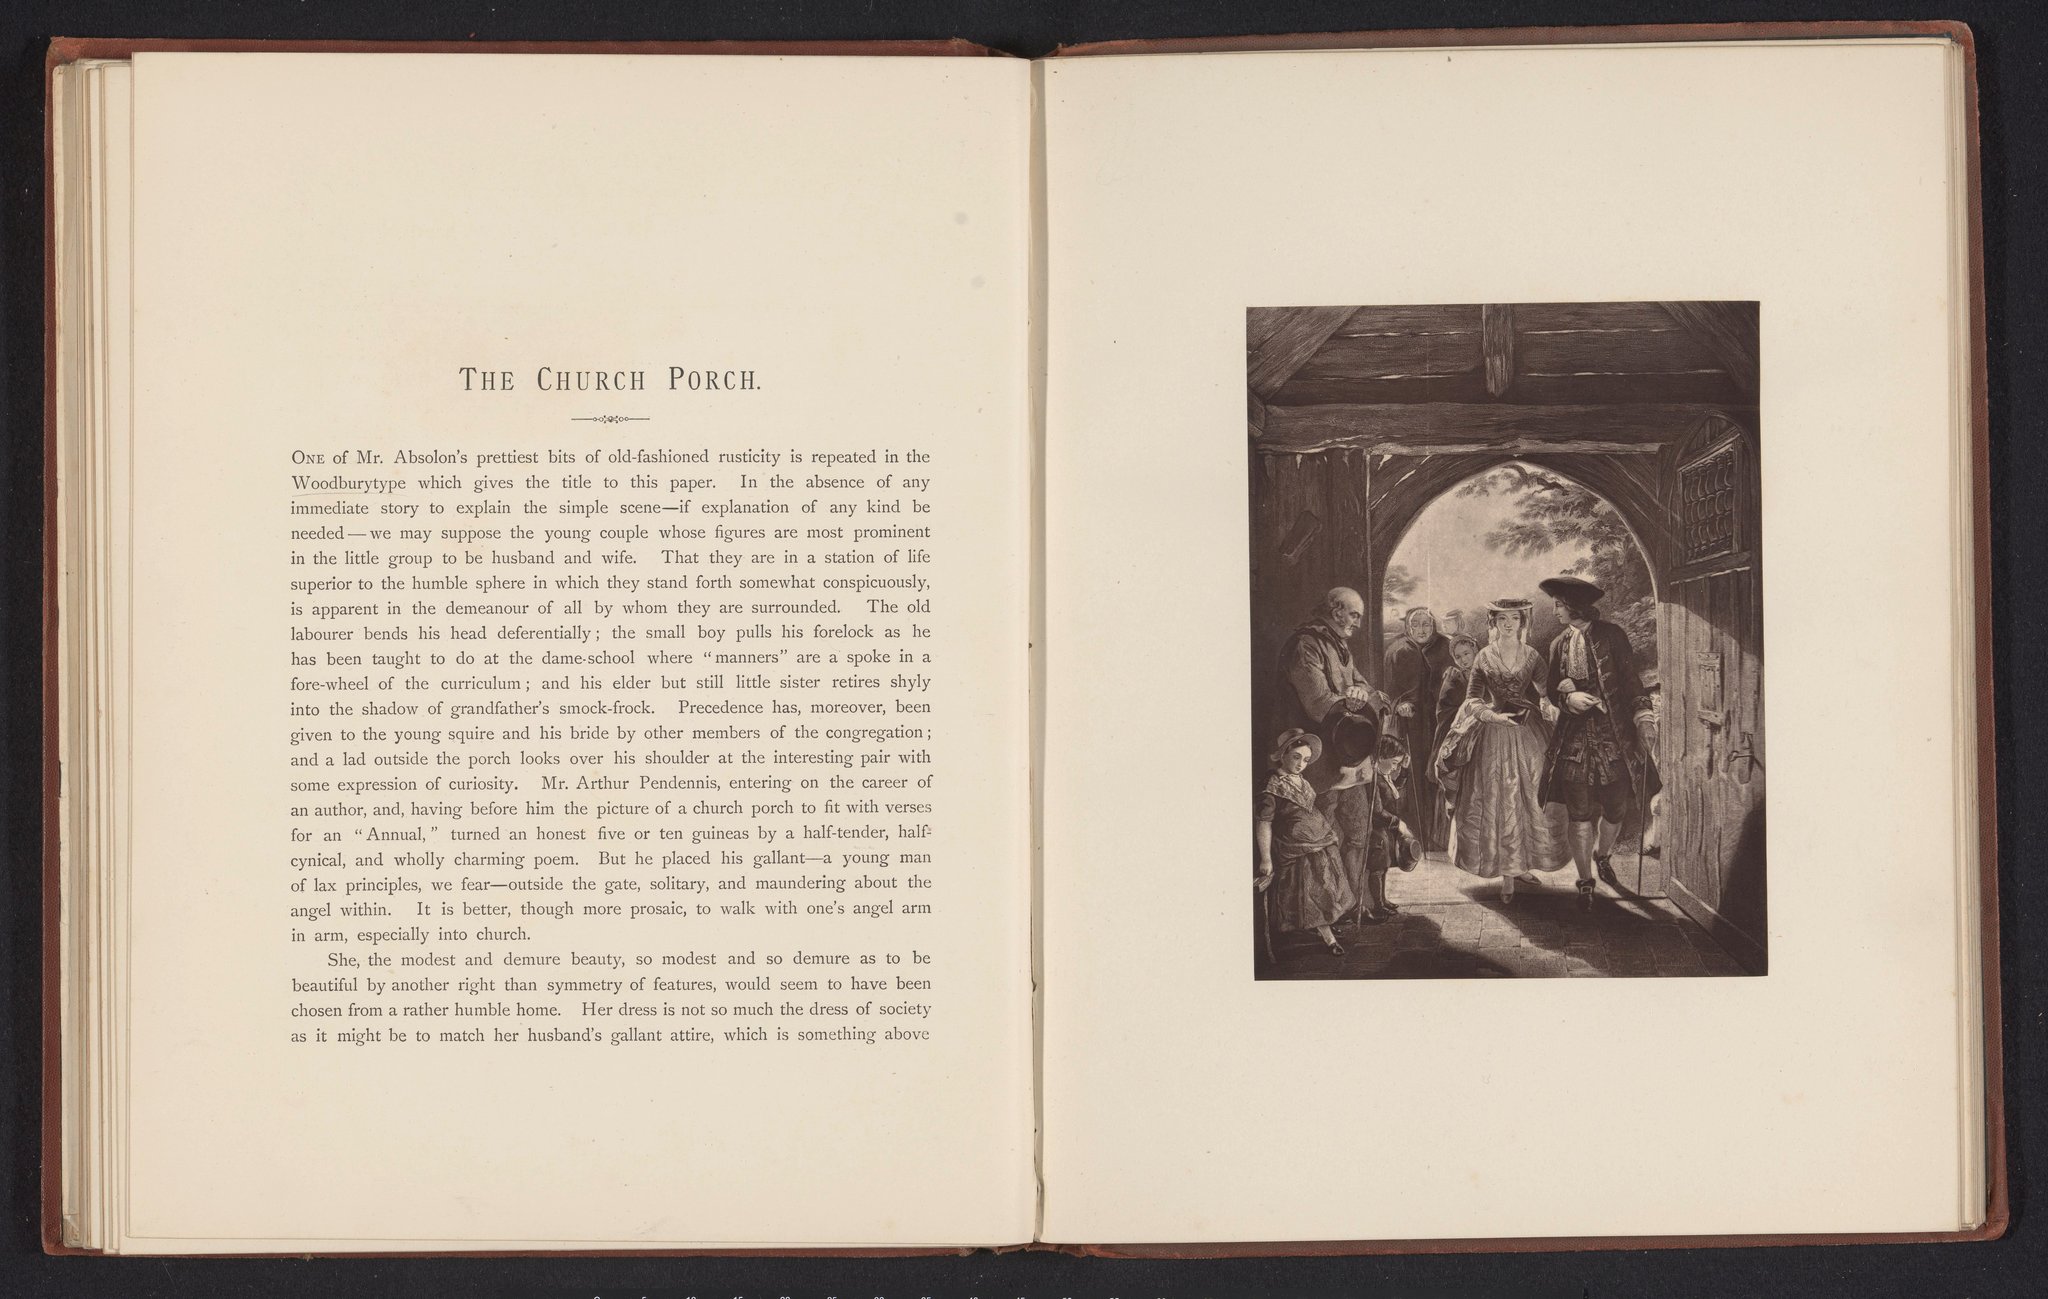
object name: page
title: Fotoreproductie van een prent naar een schilderij, voorstellende een echtpaar loopt een kerk binnen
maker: Anonymous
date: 1861-1871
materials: paper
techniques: woodburytype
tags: couple entering the church ~ marriage